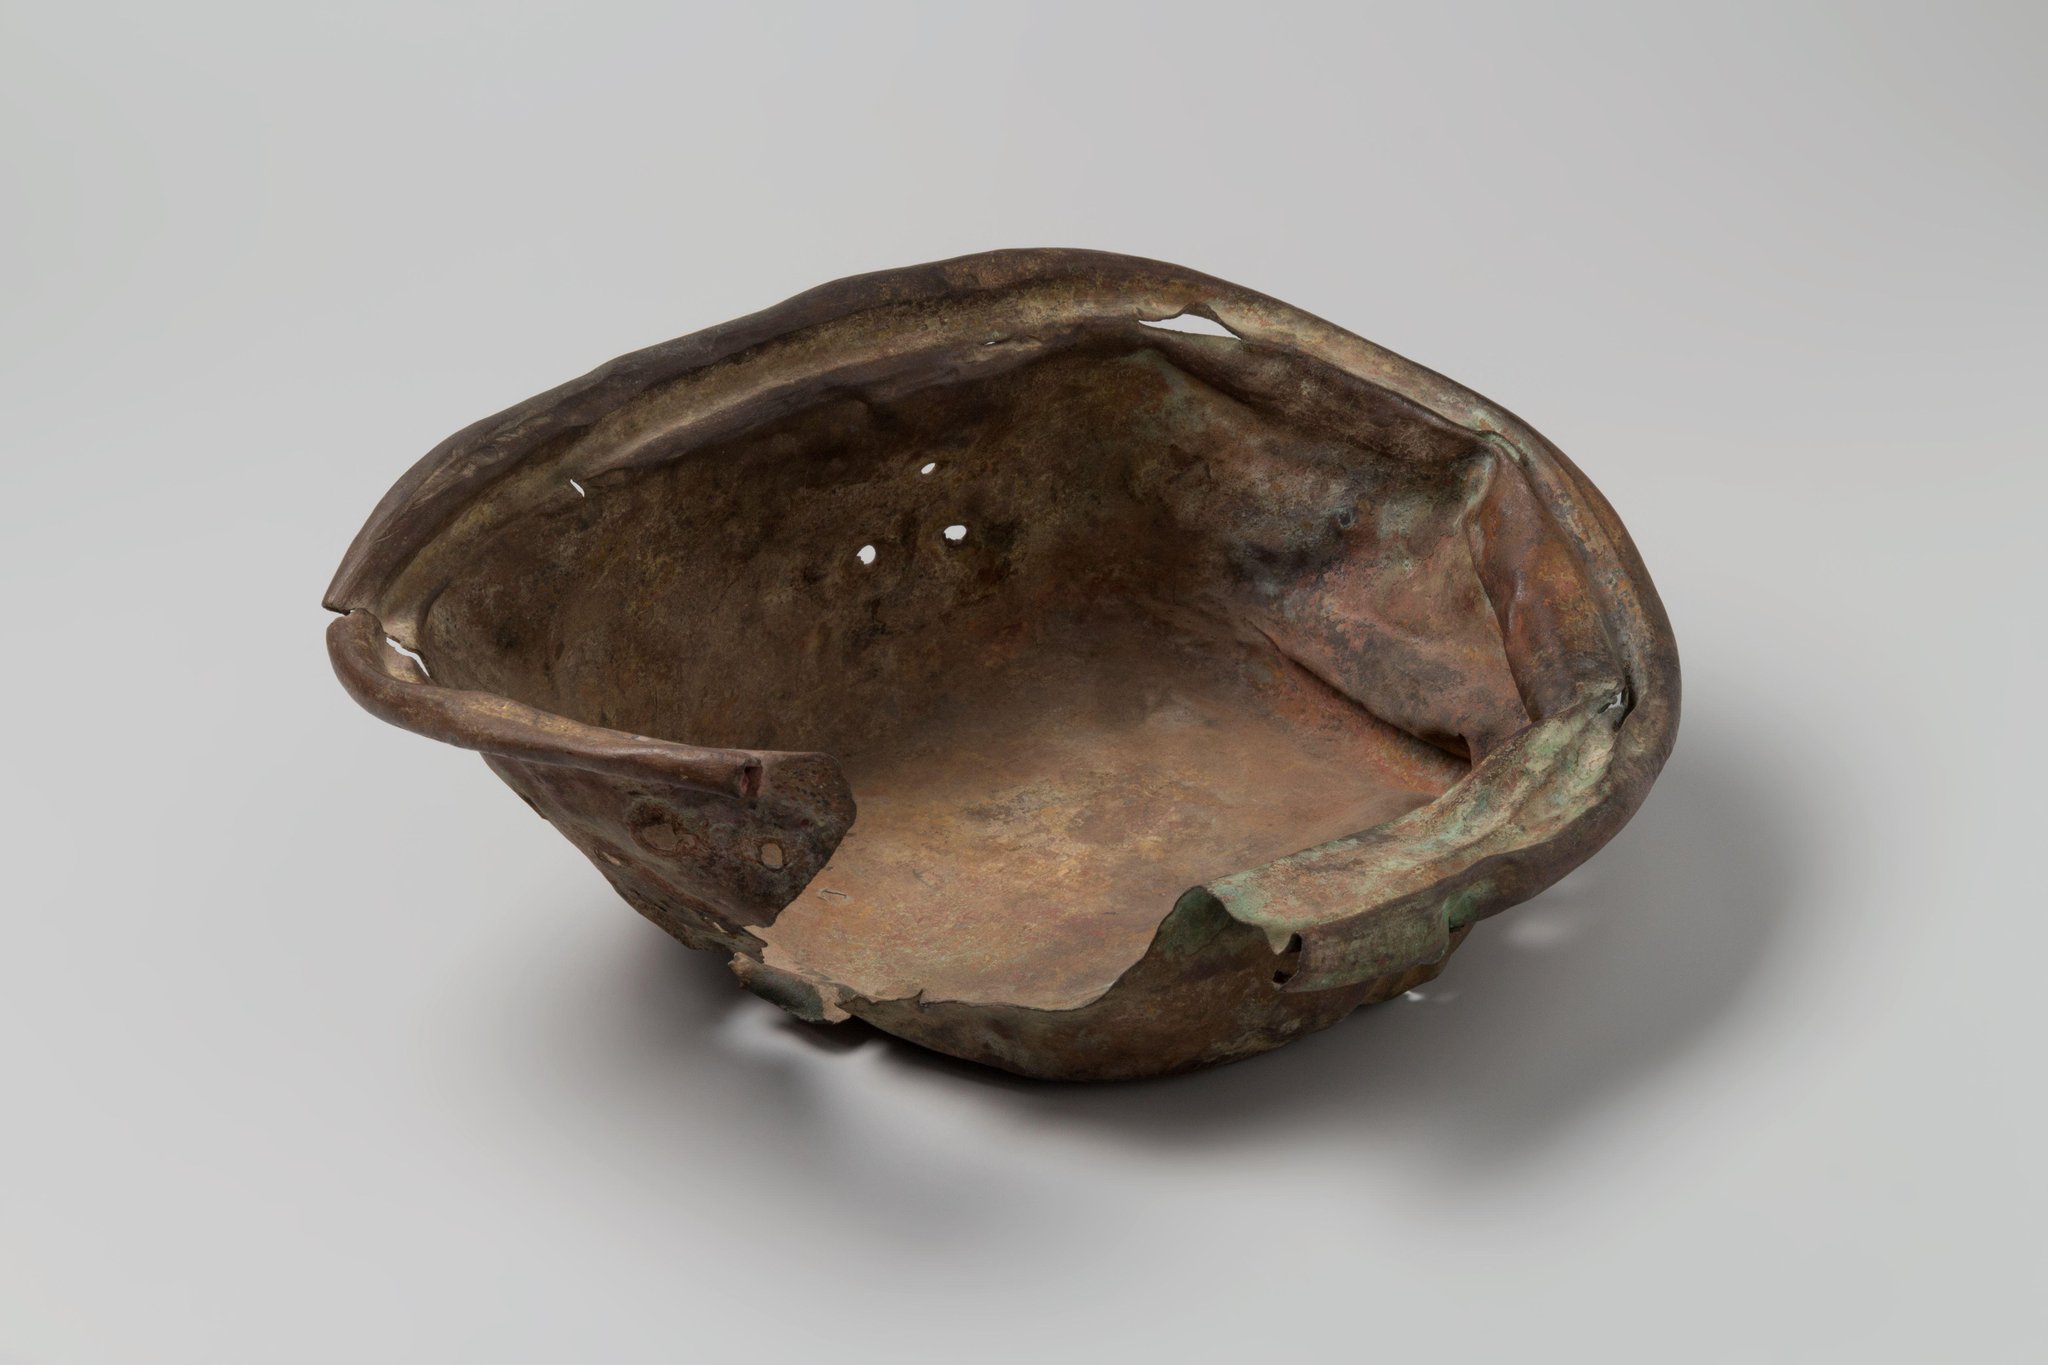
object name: drievoet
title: Drievoet pan uit het wrak van de Oost-Indiëvaarder Hollandia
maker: Anonymous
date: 1700-1743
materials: copper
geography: netherlands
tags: verenigde oostindische compagnie, hollandia (schip), annet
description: Tripod; (1) oval, flat bottom, straight sides, outward rolled rim, (2.9l, 22.5w, 11h),3 rivet-holes for each leg, handle was fitted above one of the legs with 4 rivets in semicircular row.